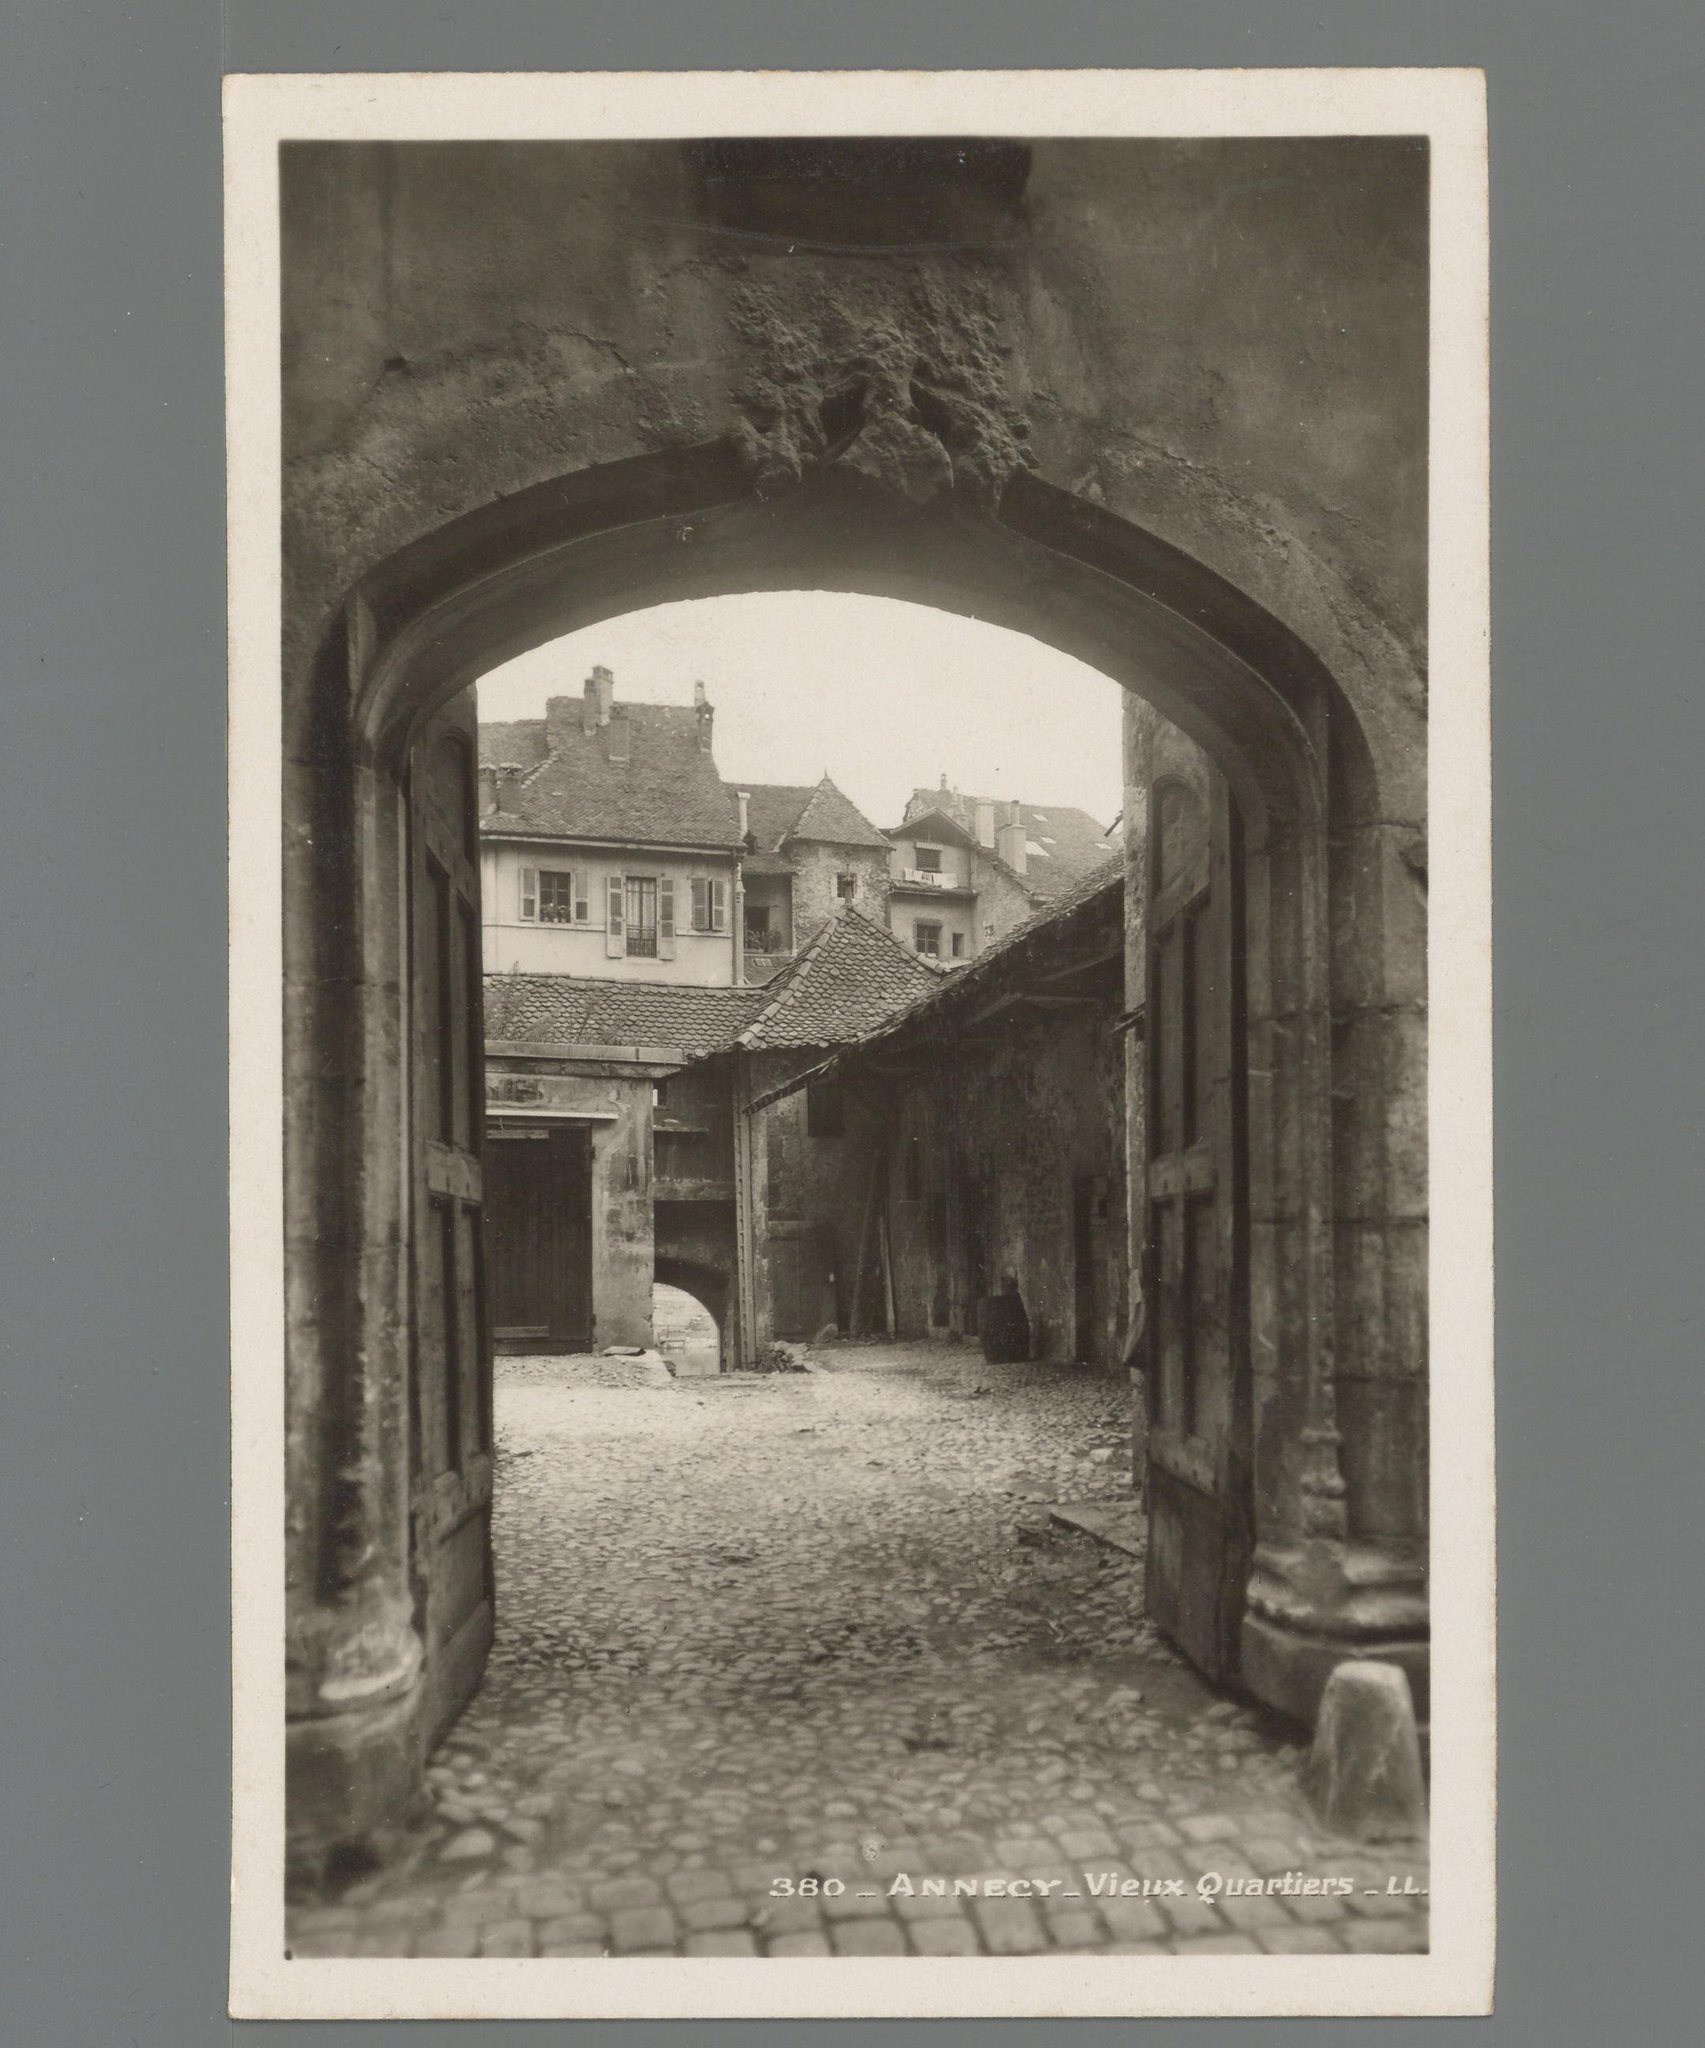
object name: ansichtkaart, prentbriefkaart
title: Annecy. Vieux Quartiers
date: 1920-1932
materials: photographic support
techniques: photography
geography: paris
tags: city-view, and landscape with man-made constructions, gate, entrance